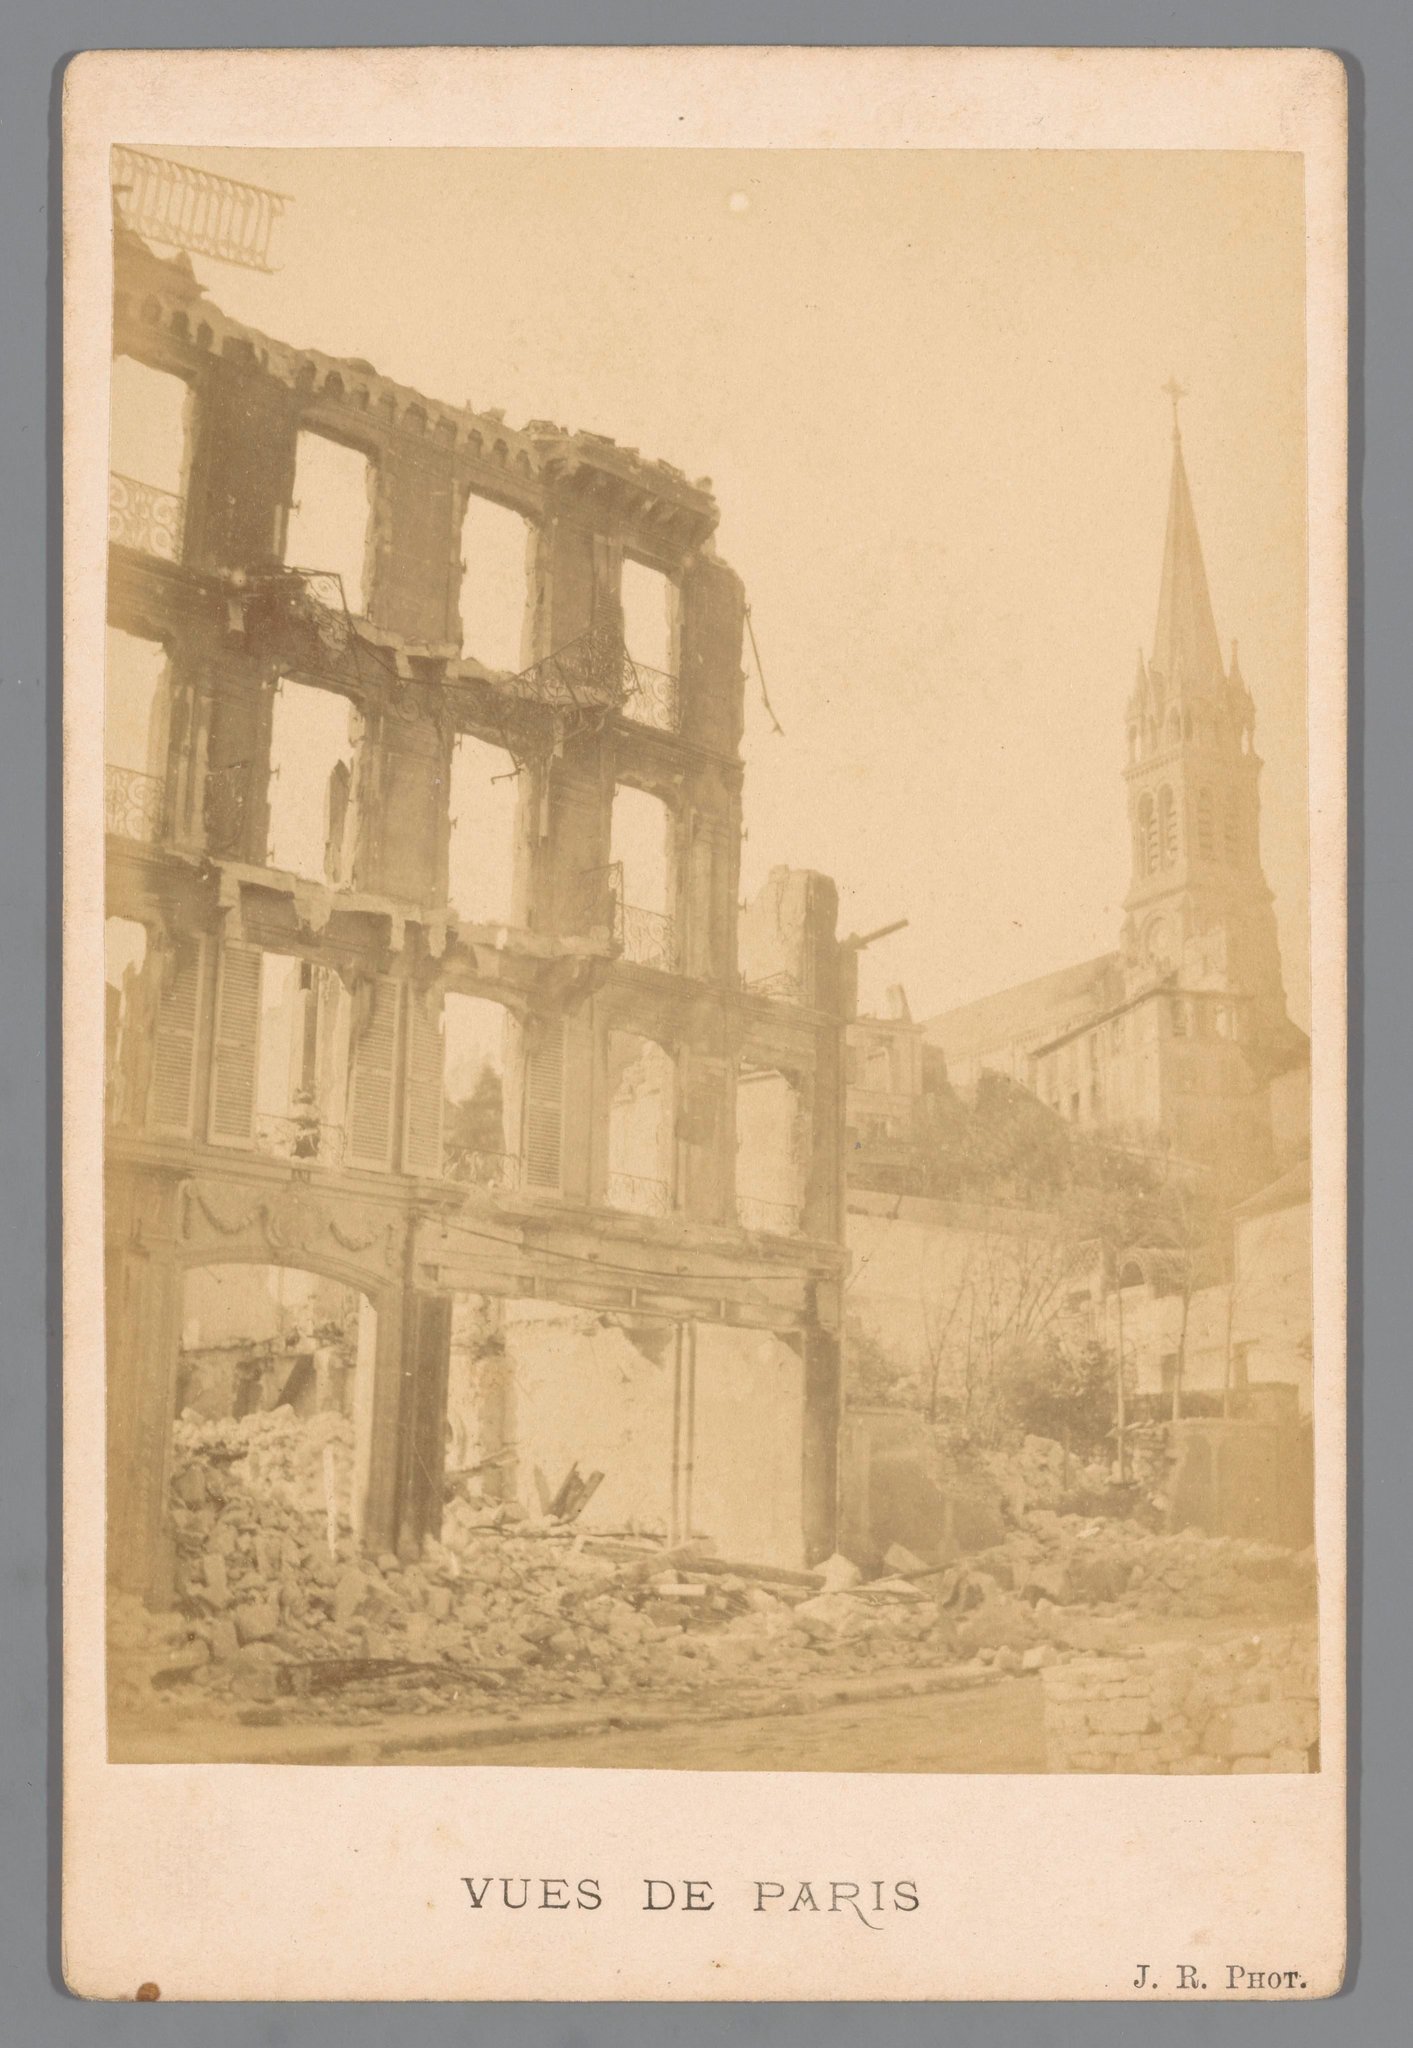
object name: cabinet photograph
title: Vues de Paris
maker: jr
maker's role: fotograaf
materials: cardboard, photographic support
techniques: albumen print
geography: saint-cloud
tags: ruin of a building ~ architecture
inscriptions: annotation: ‘Commune de St Cloud/ entièrement dévastée/ l'église seule est restée debout/ tout la reste est détruit’